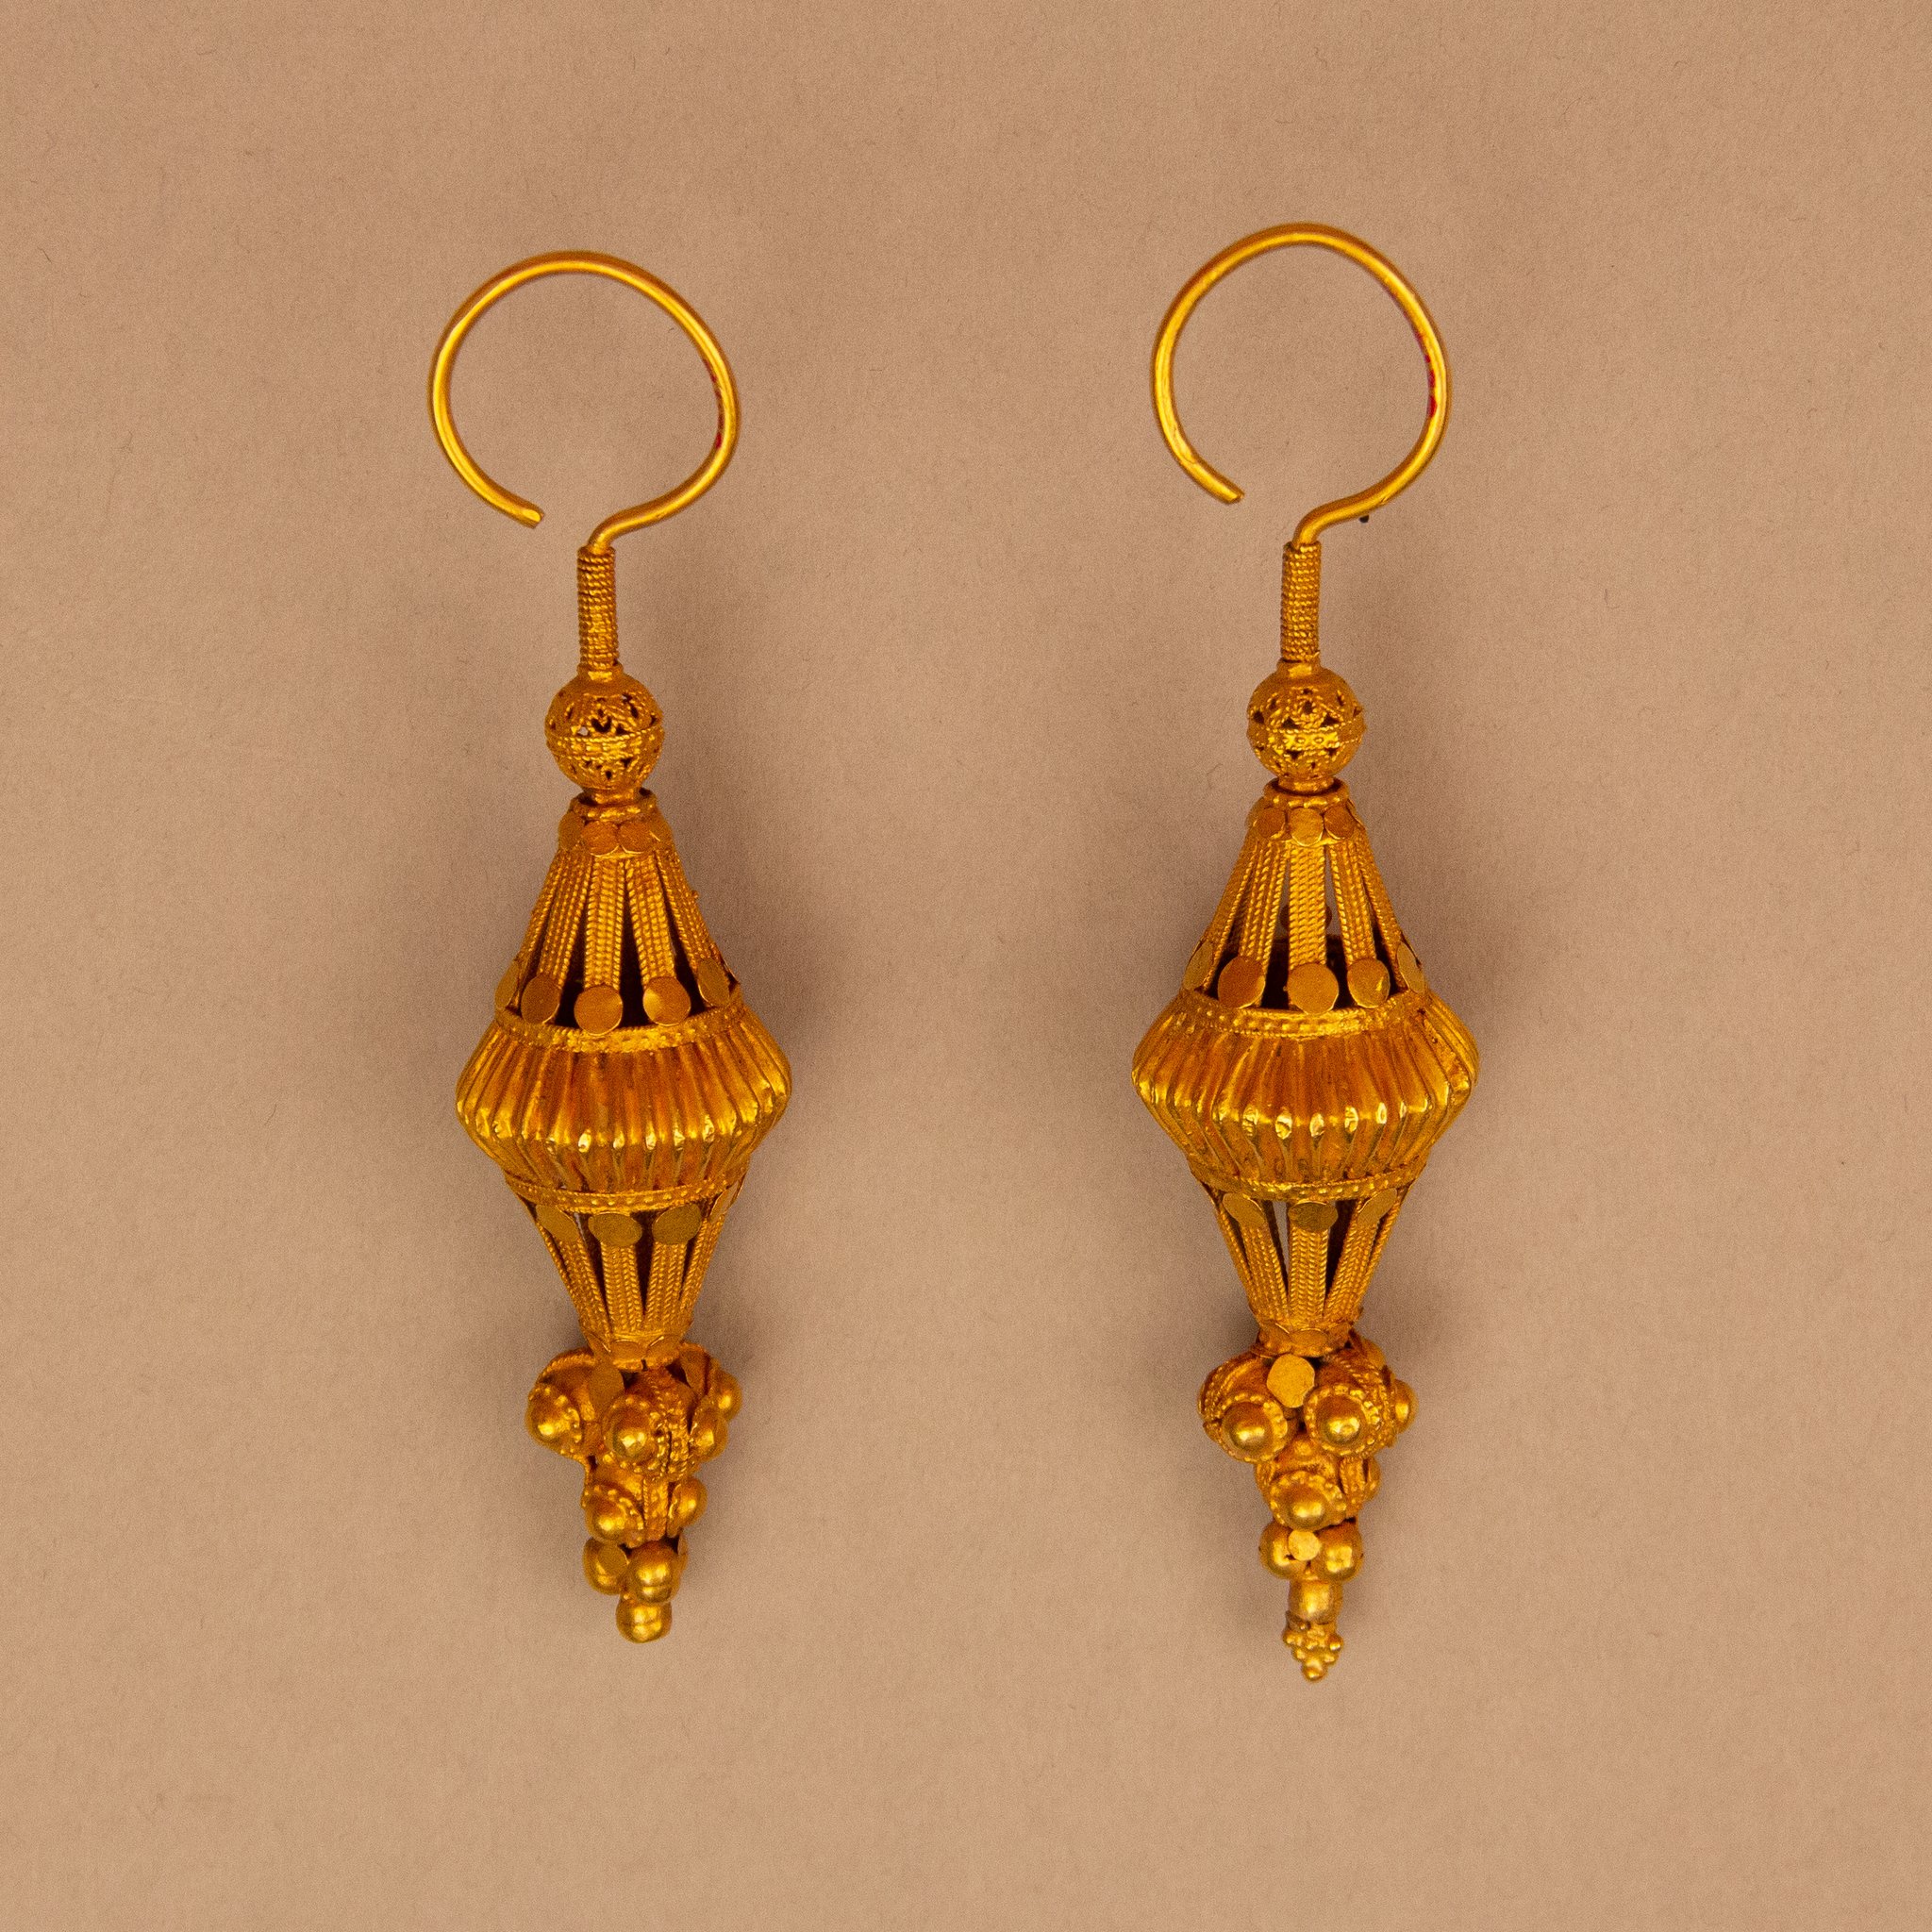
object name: earring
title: Earring, One of a Pair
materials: gold, metal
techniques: filigree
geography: saudi arabia